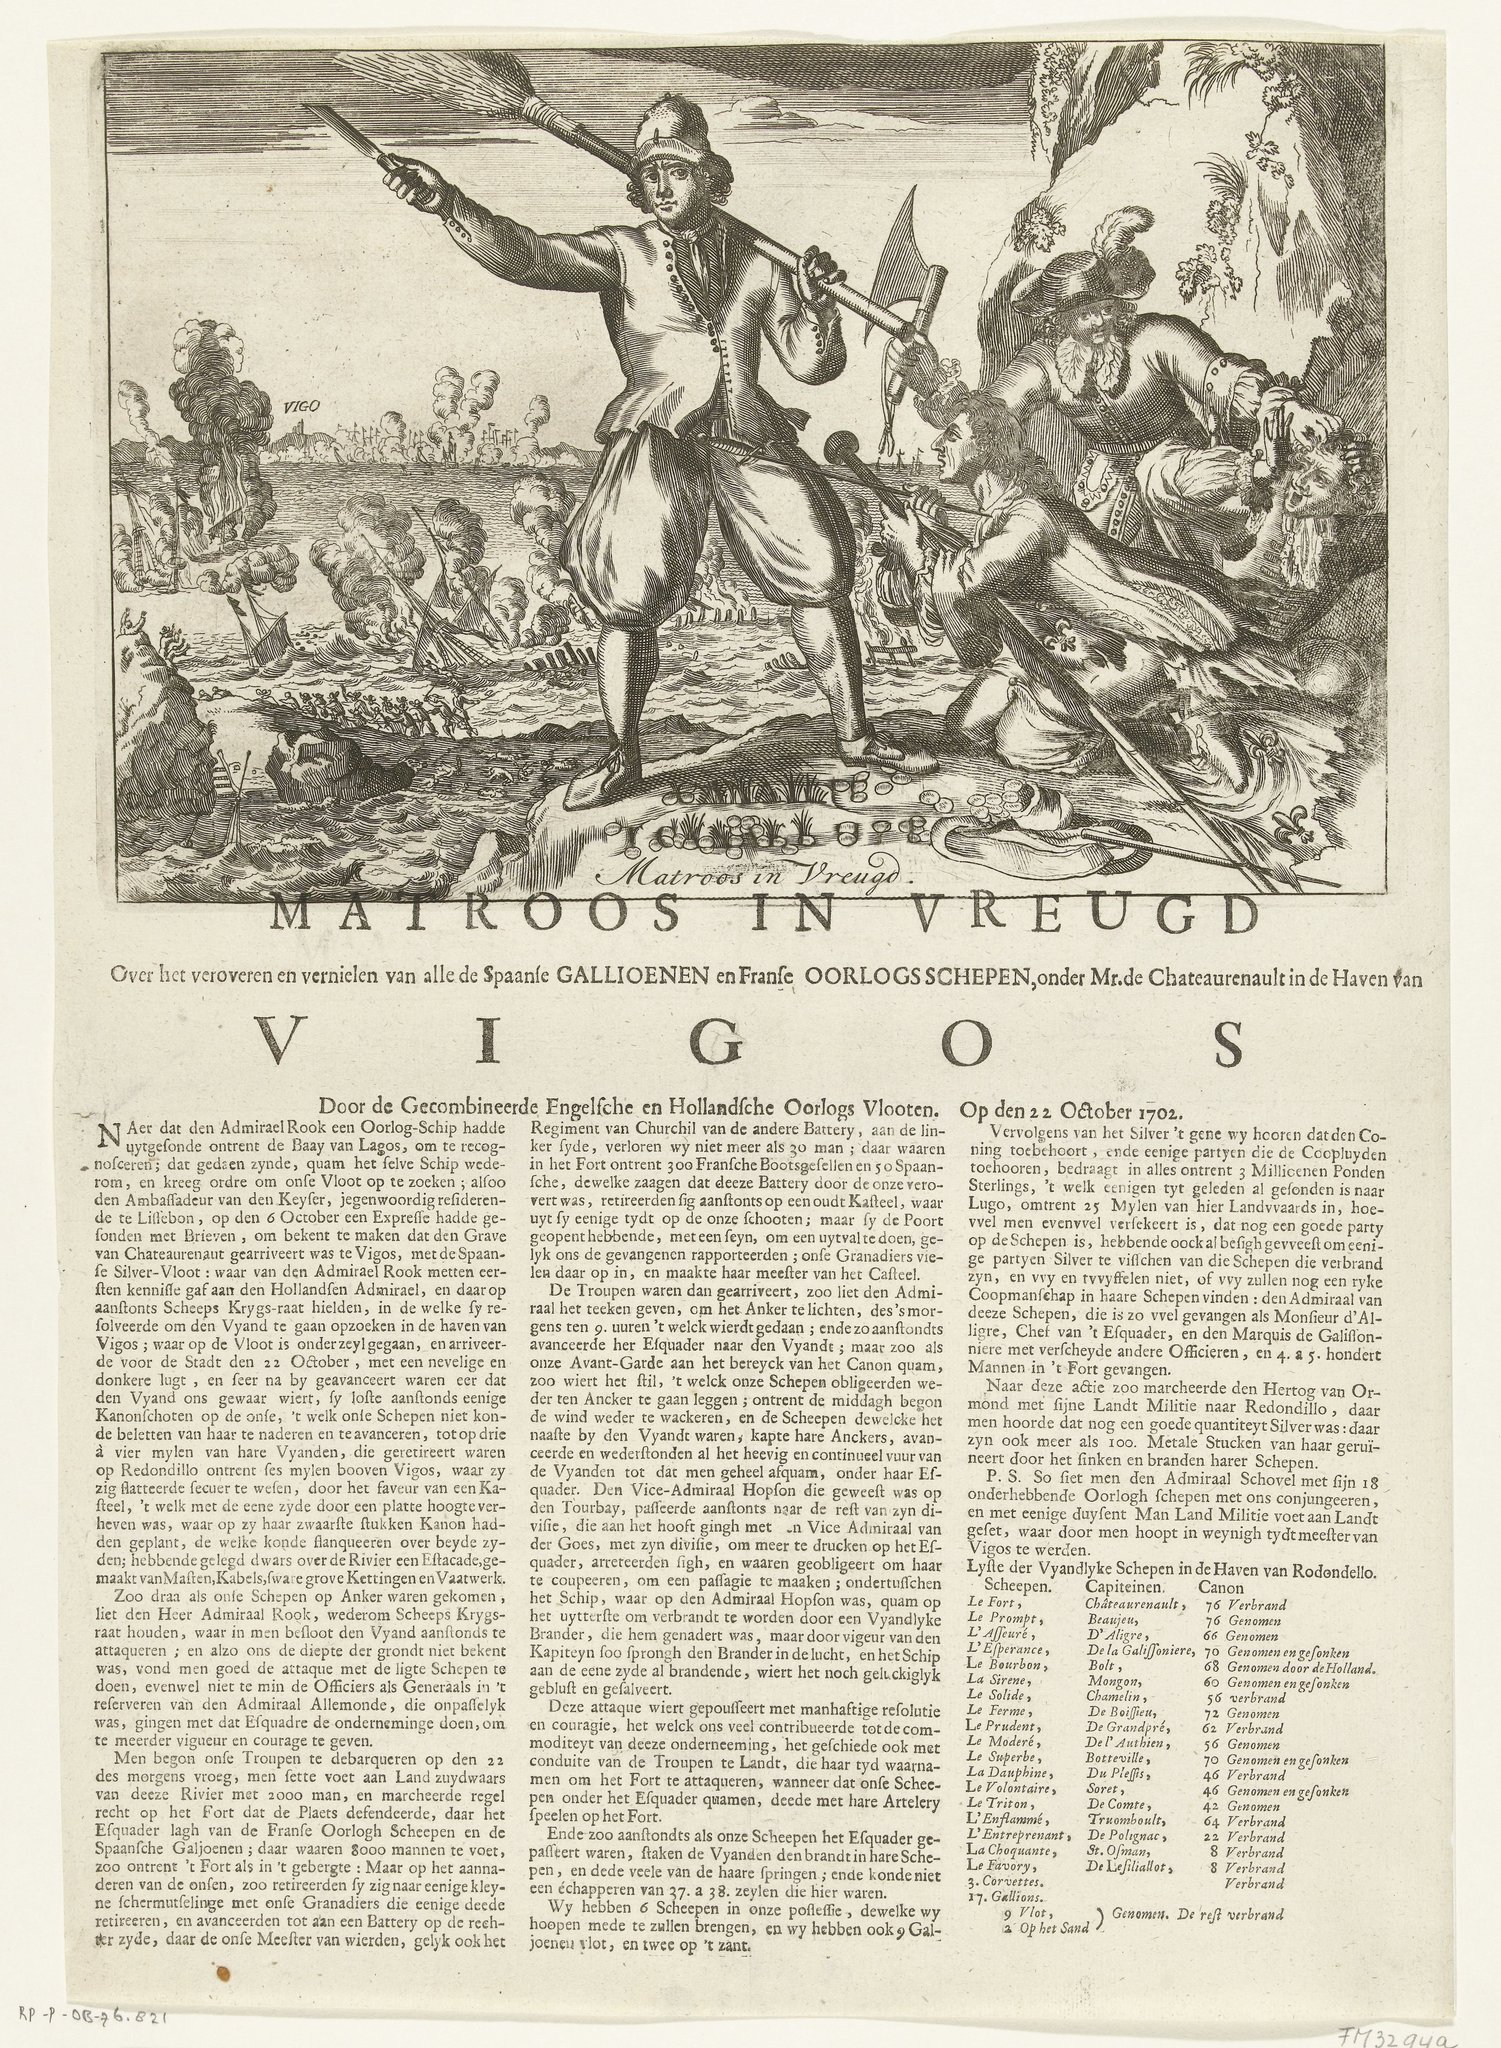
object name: cartoon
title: Matroos in Vreugd Over het veroveren en vernielen van alle de Spaanse Gallioenen en Franse Oorlogsschepen, onder Mr. de Chateaurenault in de Haven van Vigos Door de Gecombineerde Engelsche en Hollandsche Oorlogs Vlooten. Op den 22 October 1702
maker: Anonymous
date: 1692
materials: paper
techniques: engraving, etching, letterpress printing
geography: northern netherlands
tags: political caricatures and satires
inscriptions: caption: ‘Naer dat den Admirael ...De rest verbrand’, inscription: ‘Canailje/'t canael uit/Matroos in Vreugd.’, caption: ‘MATROOS IN VREUGD/Over het veroveren en vernielen ... in de Haven van /VIGOS/Door de Gecombineerde ... 22 October 1702’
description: Spotprent op de overwinning van de Engelsen en Hollanders op de Fransen en Spanjaarden in de zeeslag bij Vigo, 23 oktober 1702. De Hollandse matroos met bezem over de schouder staat op rots bij zee waarop schepen aan het vergaan zijn. Aan zijn voeten smeekt een Fransman om genade. Rechts bedreigt een Engelsman een Spanjaard met een hakbijl. Op het blad onder de plaat een tekst in het Nederlands in 3 kolommen.